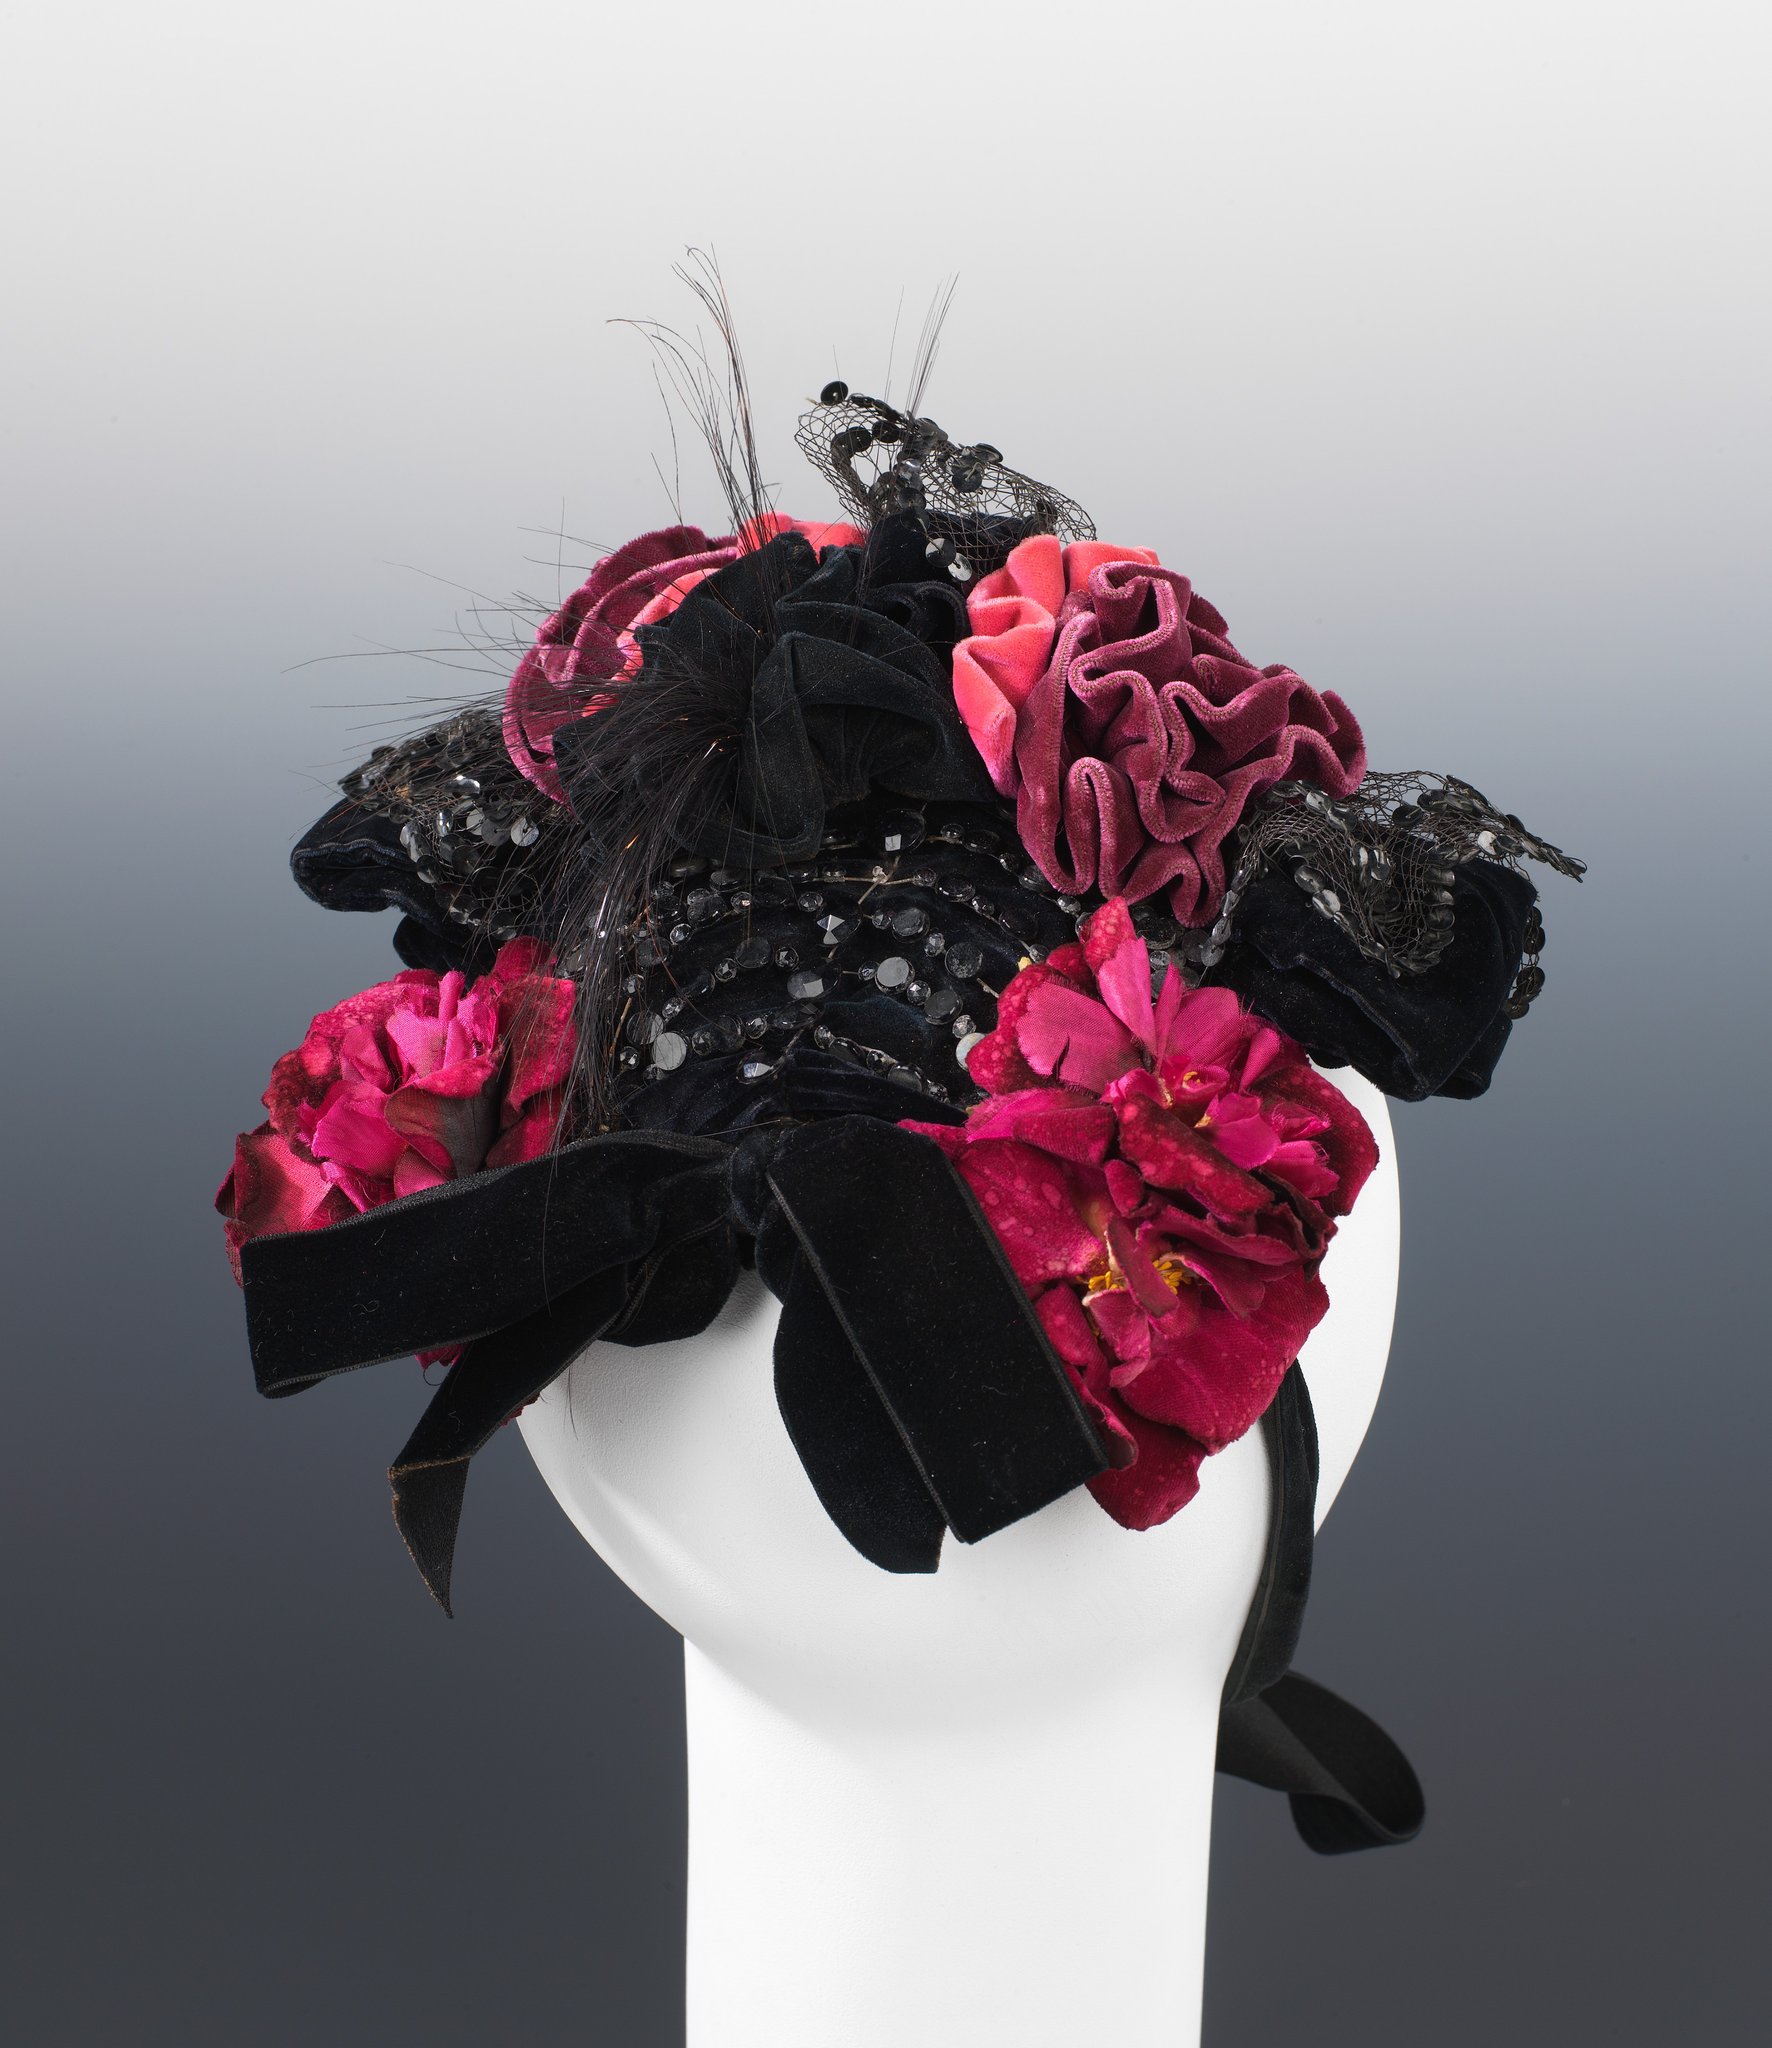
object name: evening bonnet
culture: american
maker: journeay & burnham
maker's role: department store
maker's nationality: american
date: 1892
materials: cotton, feather, silk